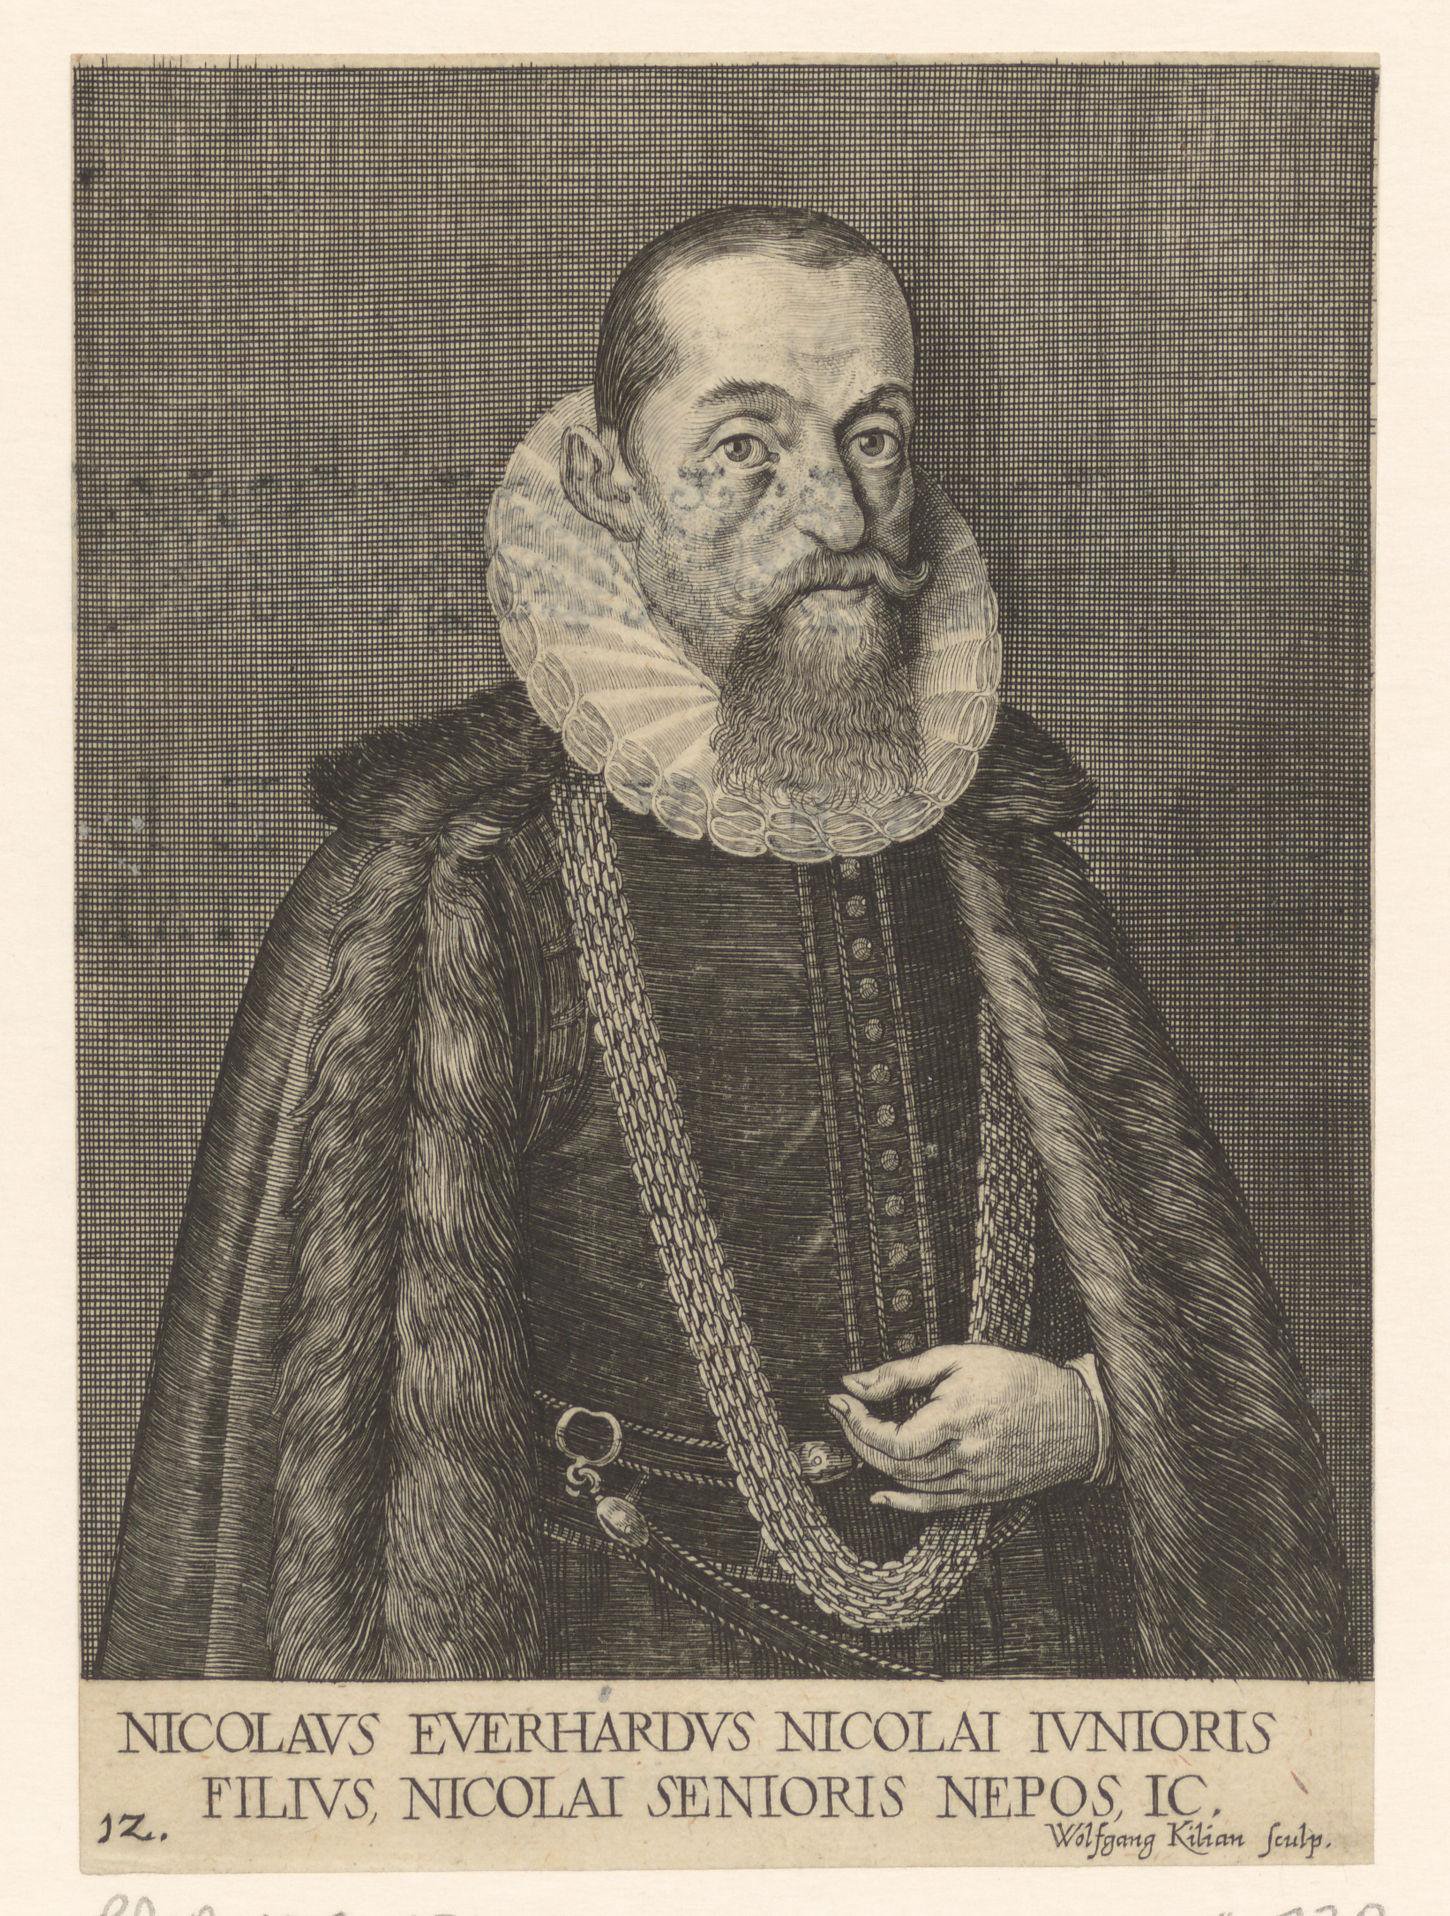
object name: print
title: Portret van Nicolaus Everardi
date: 1620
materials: paper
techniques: engraving, letterpress printing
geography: augsburg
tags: mechelen, historical persons, lawyer, attorney at law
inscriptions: collector's mark: Lugt 2228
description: Dit is de twaalfde prent uit een reeks van twintig afbeeldingen van de mannen uit de familie Eberhard, bewerkt (mogelijk gedrukt) door Sara Mang en uitgegeven in Augsburg in 1620.